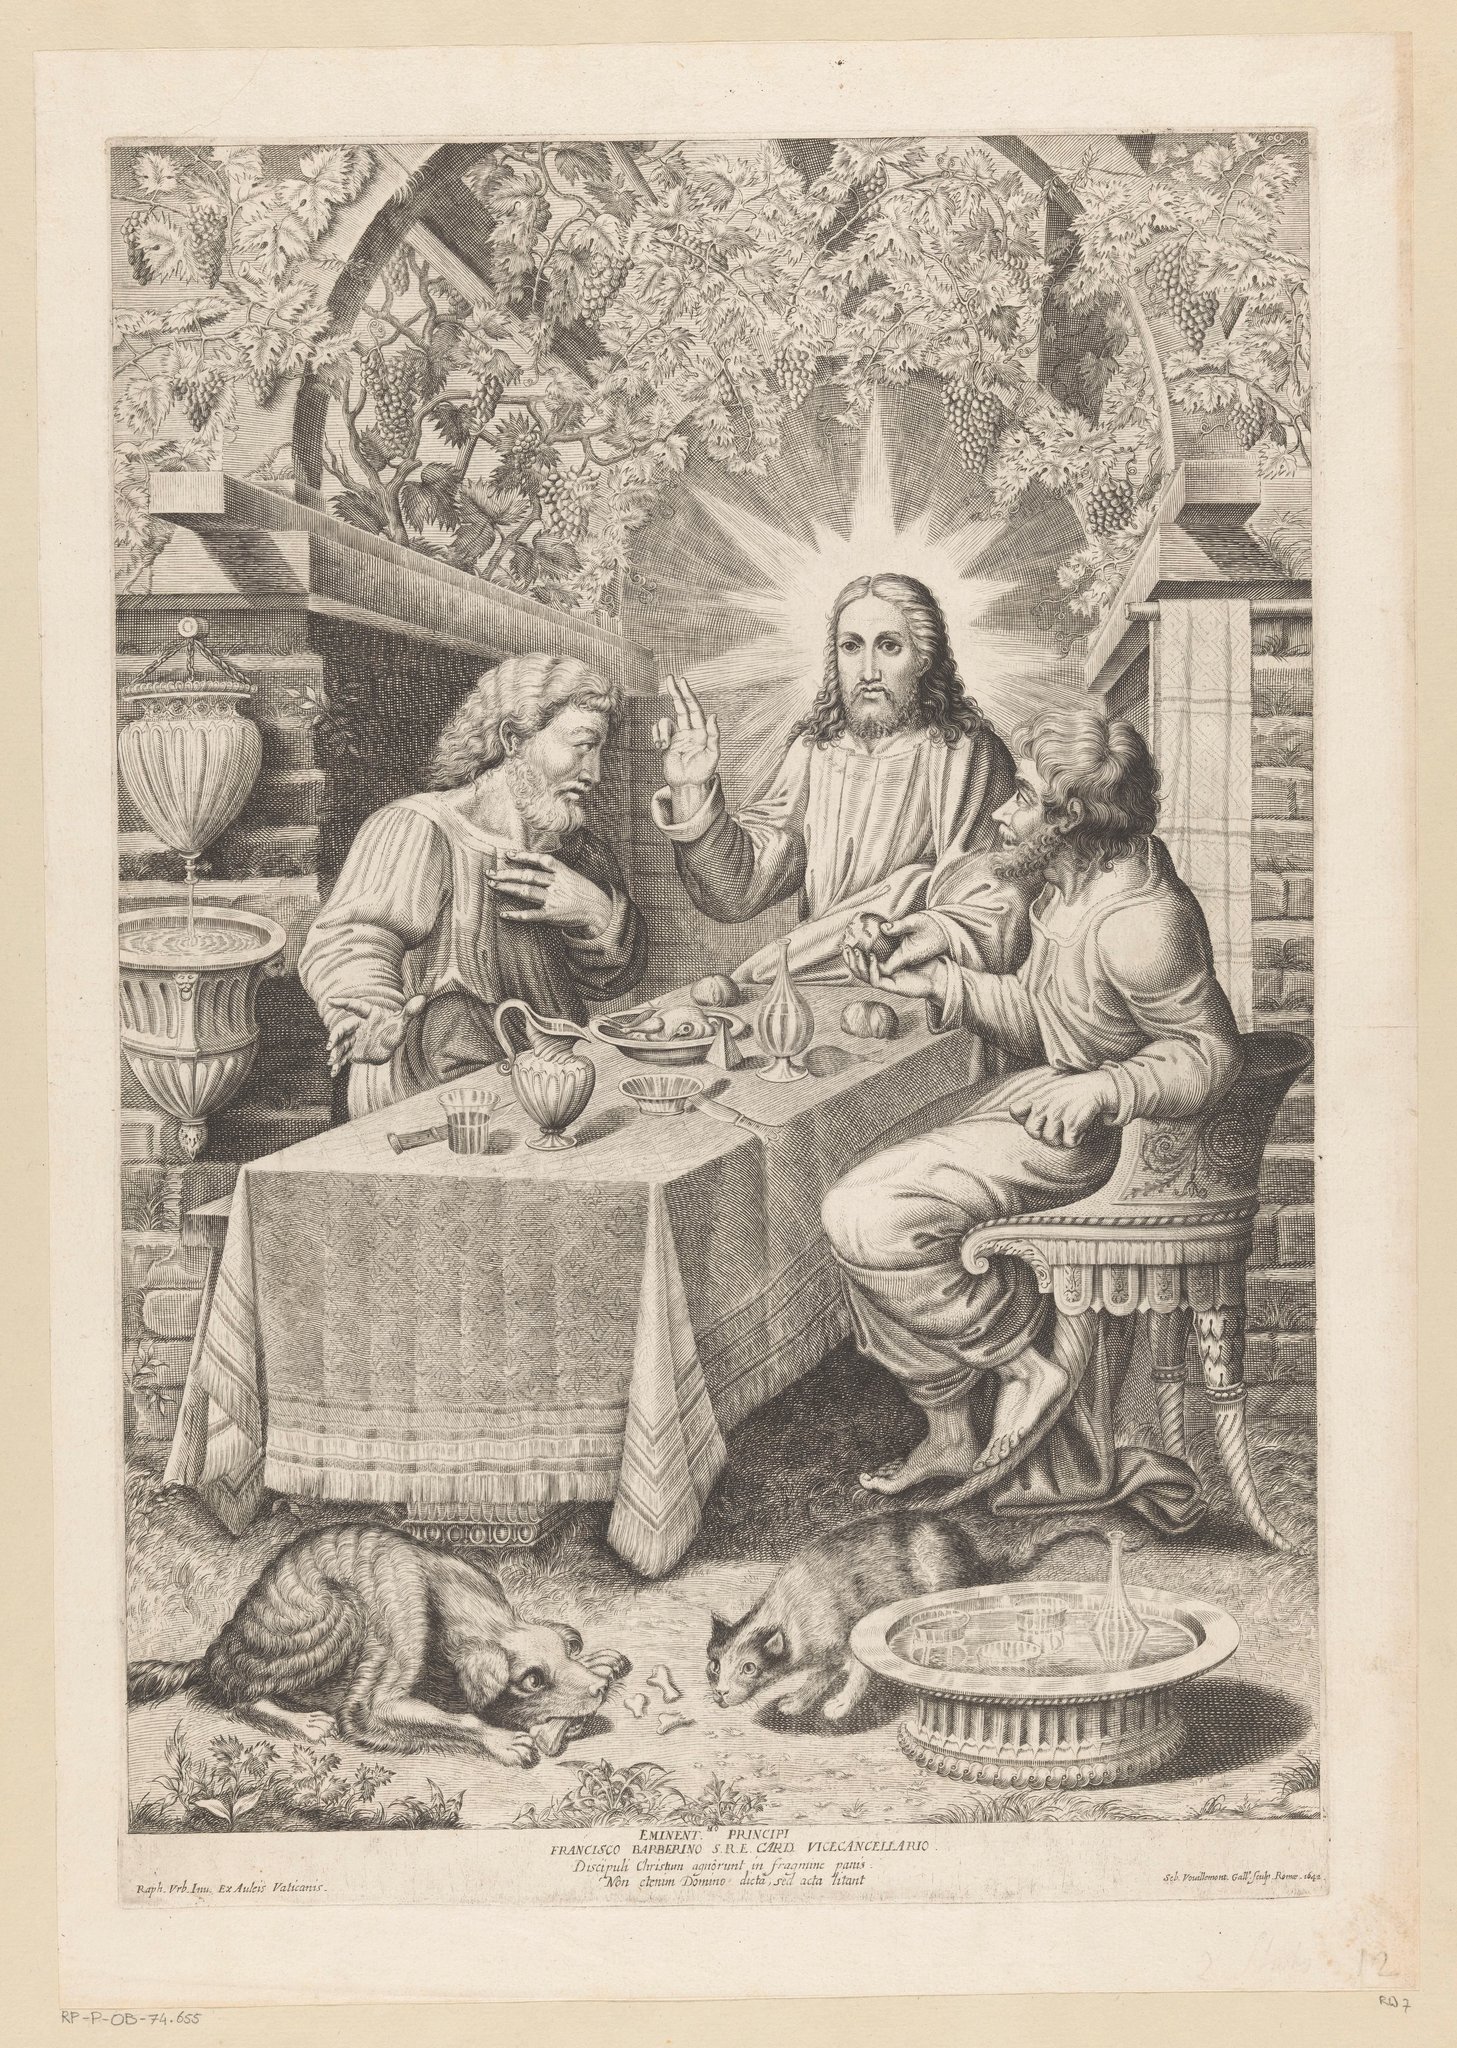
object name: print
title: Maaltijd te Emmaüs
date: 1642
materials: paper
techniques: engraving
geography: vatican city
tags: cat, the supper at emmaus: christ is recognized while blessing or breaking the bread, dog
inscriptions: collector's mark: Lugt 240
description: Ontwerp naar een wandtapijt in de Galleria degli Arazzi in de Vaticaanse Musea.